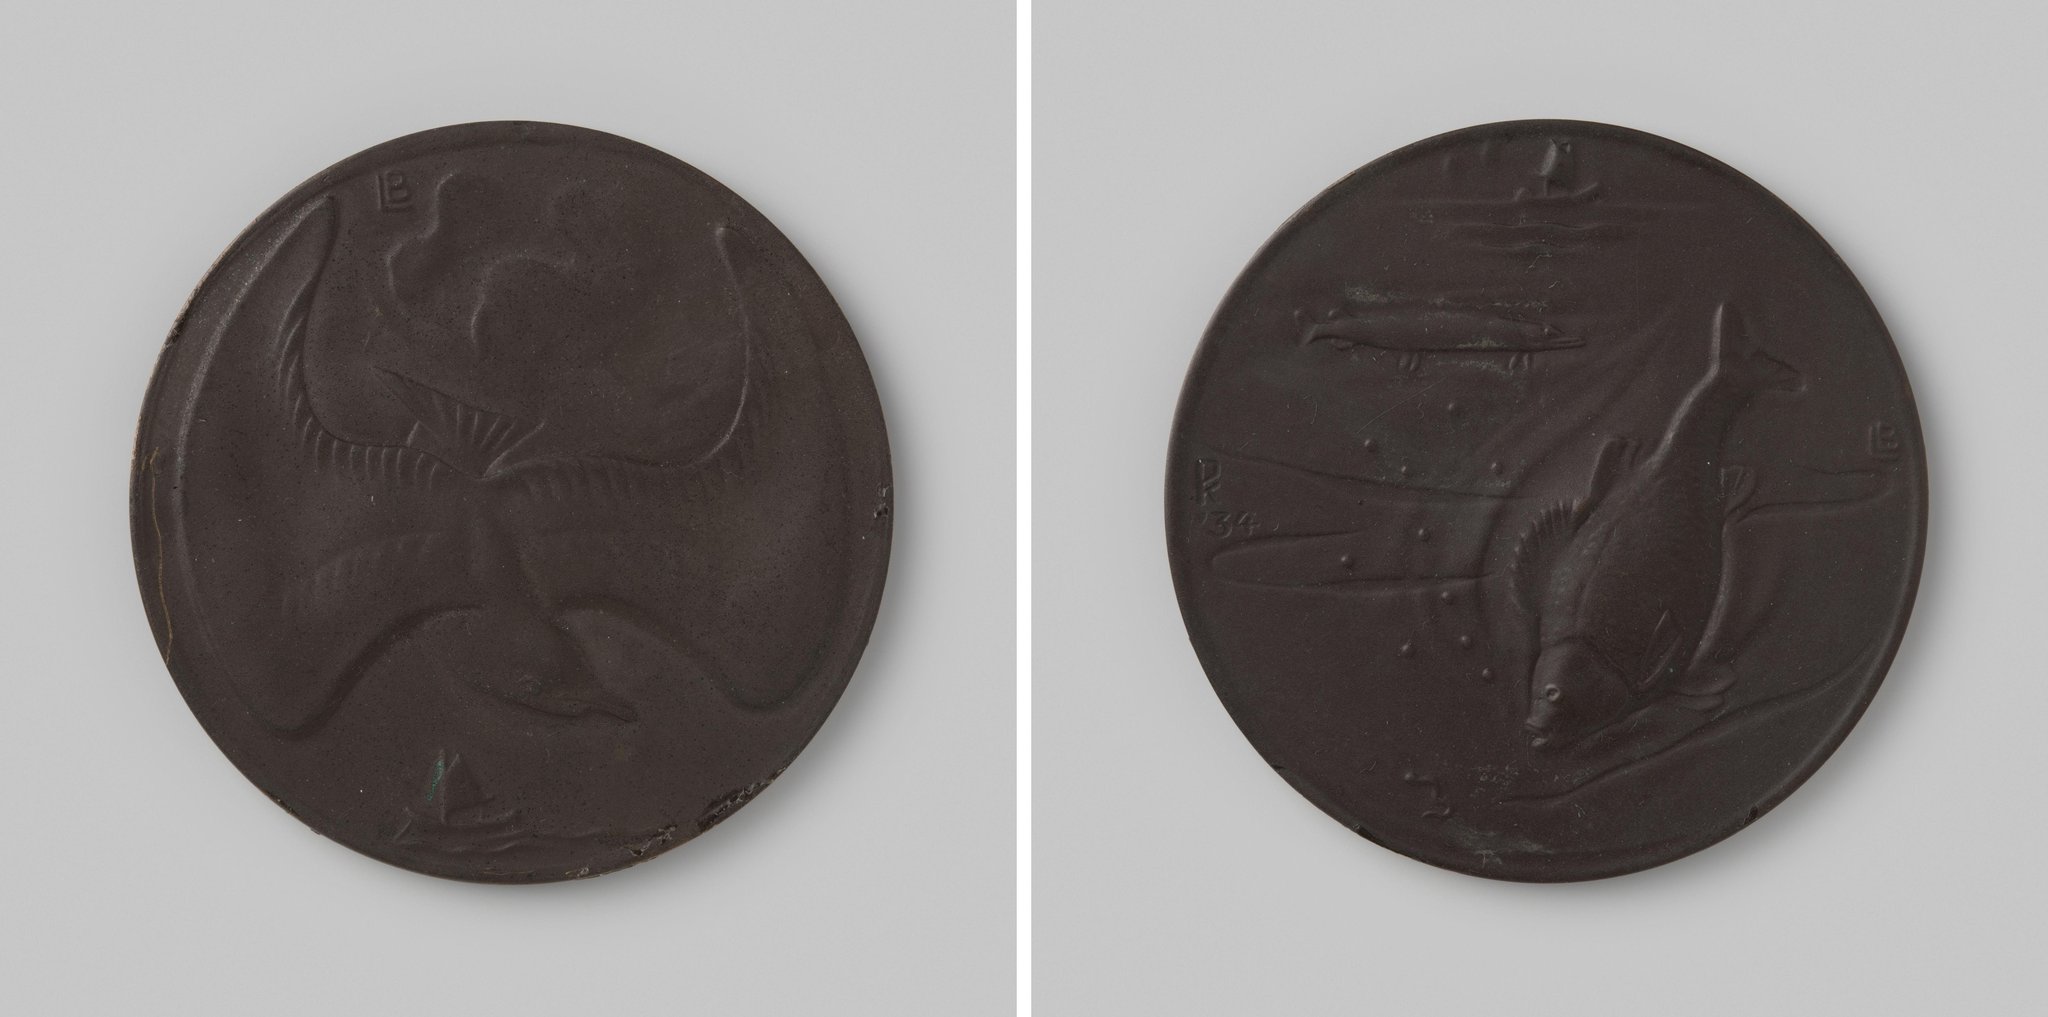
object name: medal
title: Lucht en water (Vereniging voor Penningkunst 1934, eerste penning)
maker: leendert bolle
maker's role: painter, sculptor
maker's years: 1879-1942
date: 1934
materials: bronze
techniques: striking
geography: voorschoten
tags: water (one of the four elements), air (one of the four elements), birds, fishes